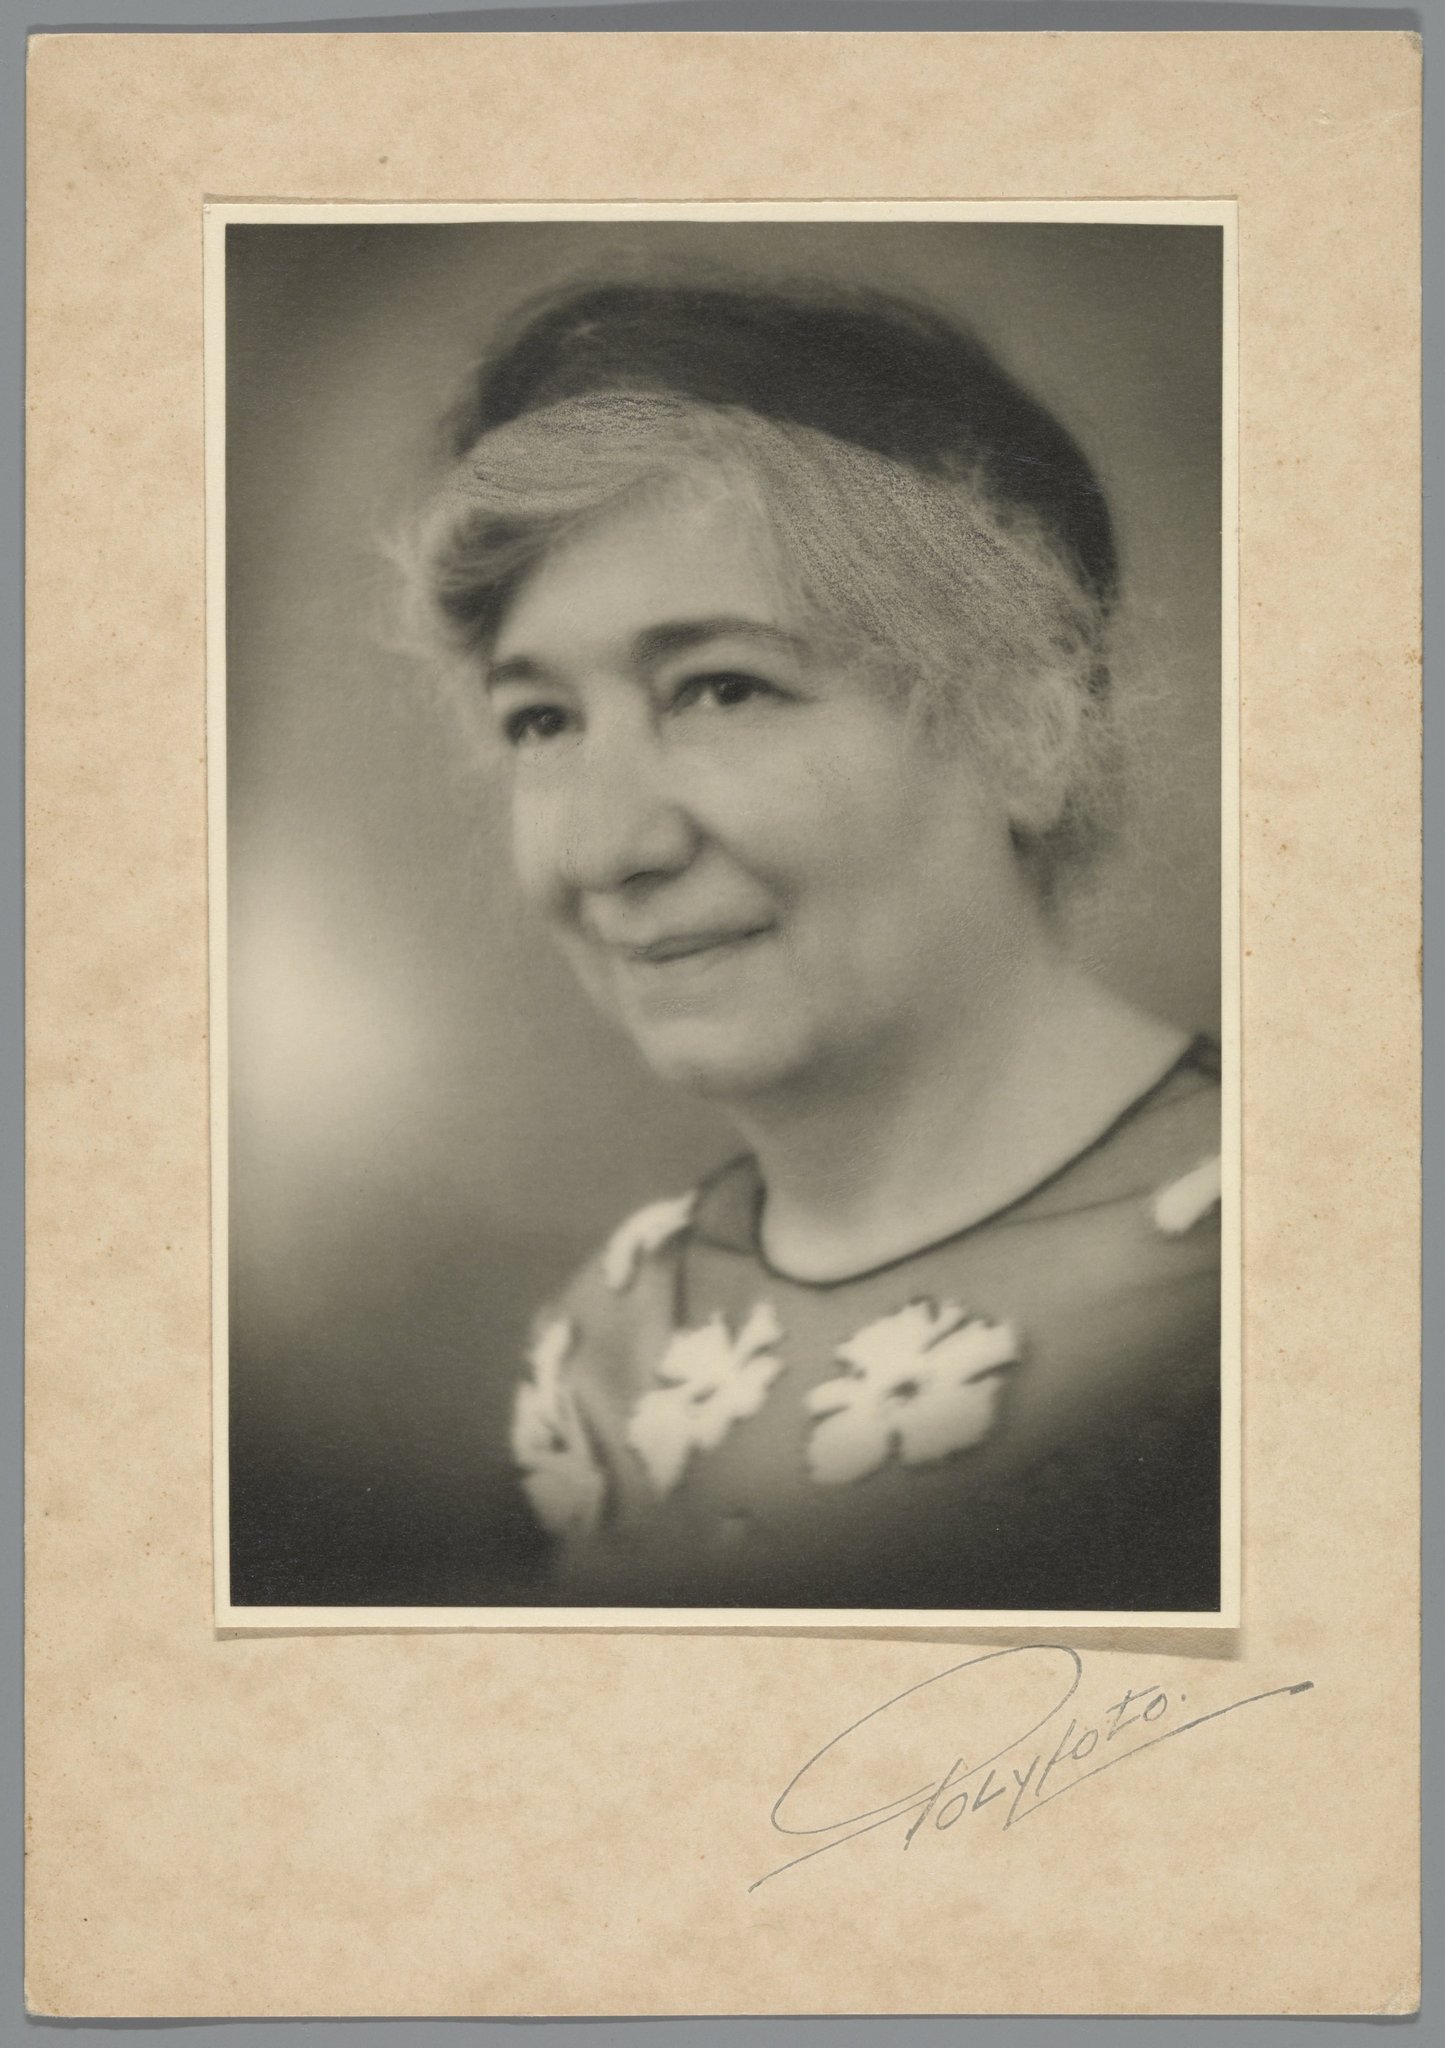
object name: photograph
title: Marie Witsen-Schorr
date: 1860-1915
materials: paper, photographic support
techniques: gelatin silver print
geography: netherlands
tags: amsterdam, augusta maria agnes witsen-schorr